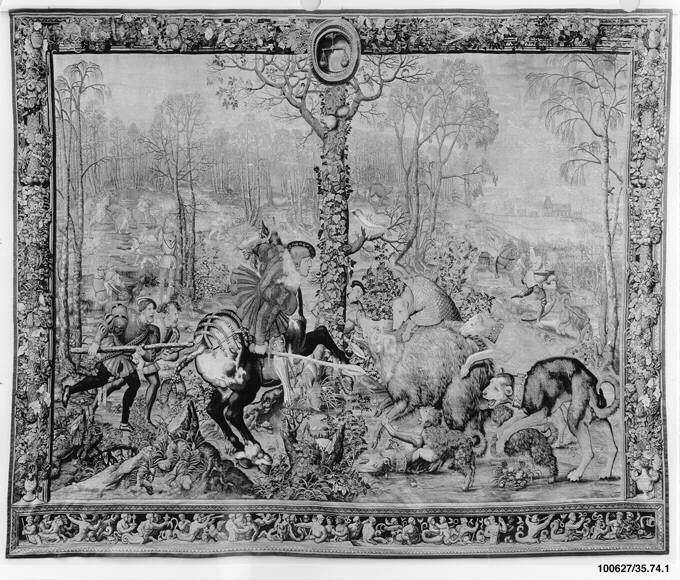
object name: tapestry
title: The Final Assault on the Boar, or December from a set of the Hunts of Maximilian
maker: bernard van orley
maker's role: designer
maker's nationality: netherlandish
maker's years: 1492-1542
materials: silk, wool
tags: birds,men,hunting,boars,dogs,horses,forests